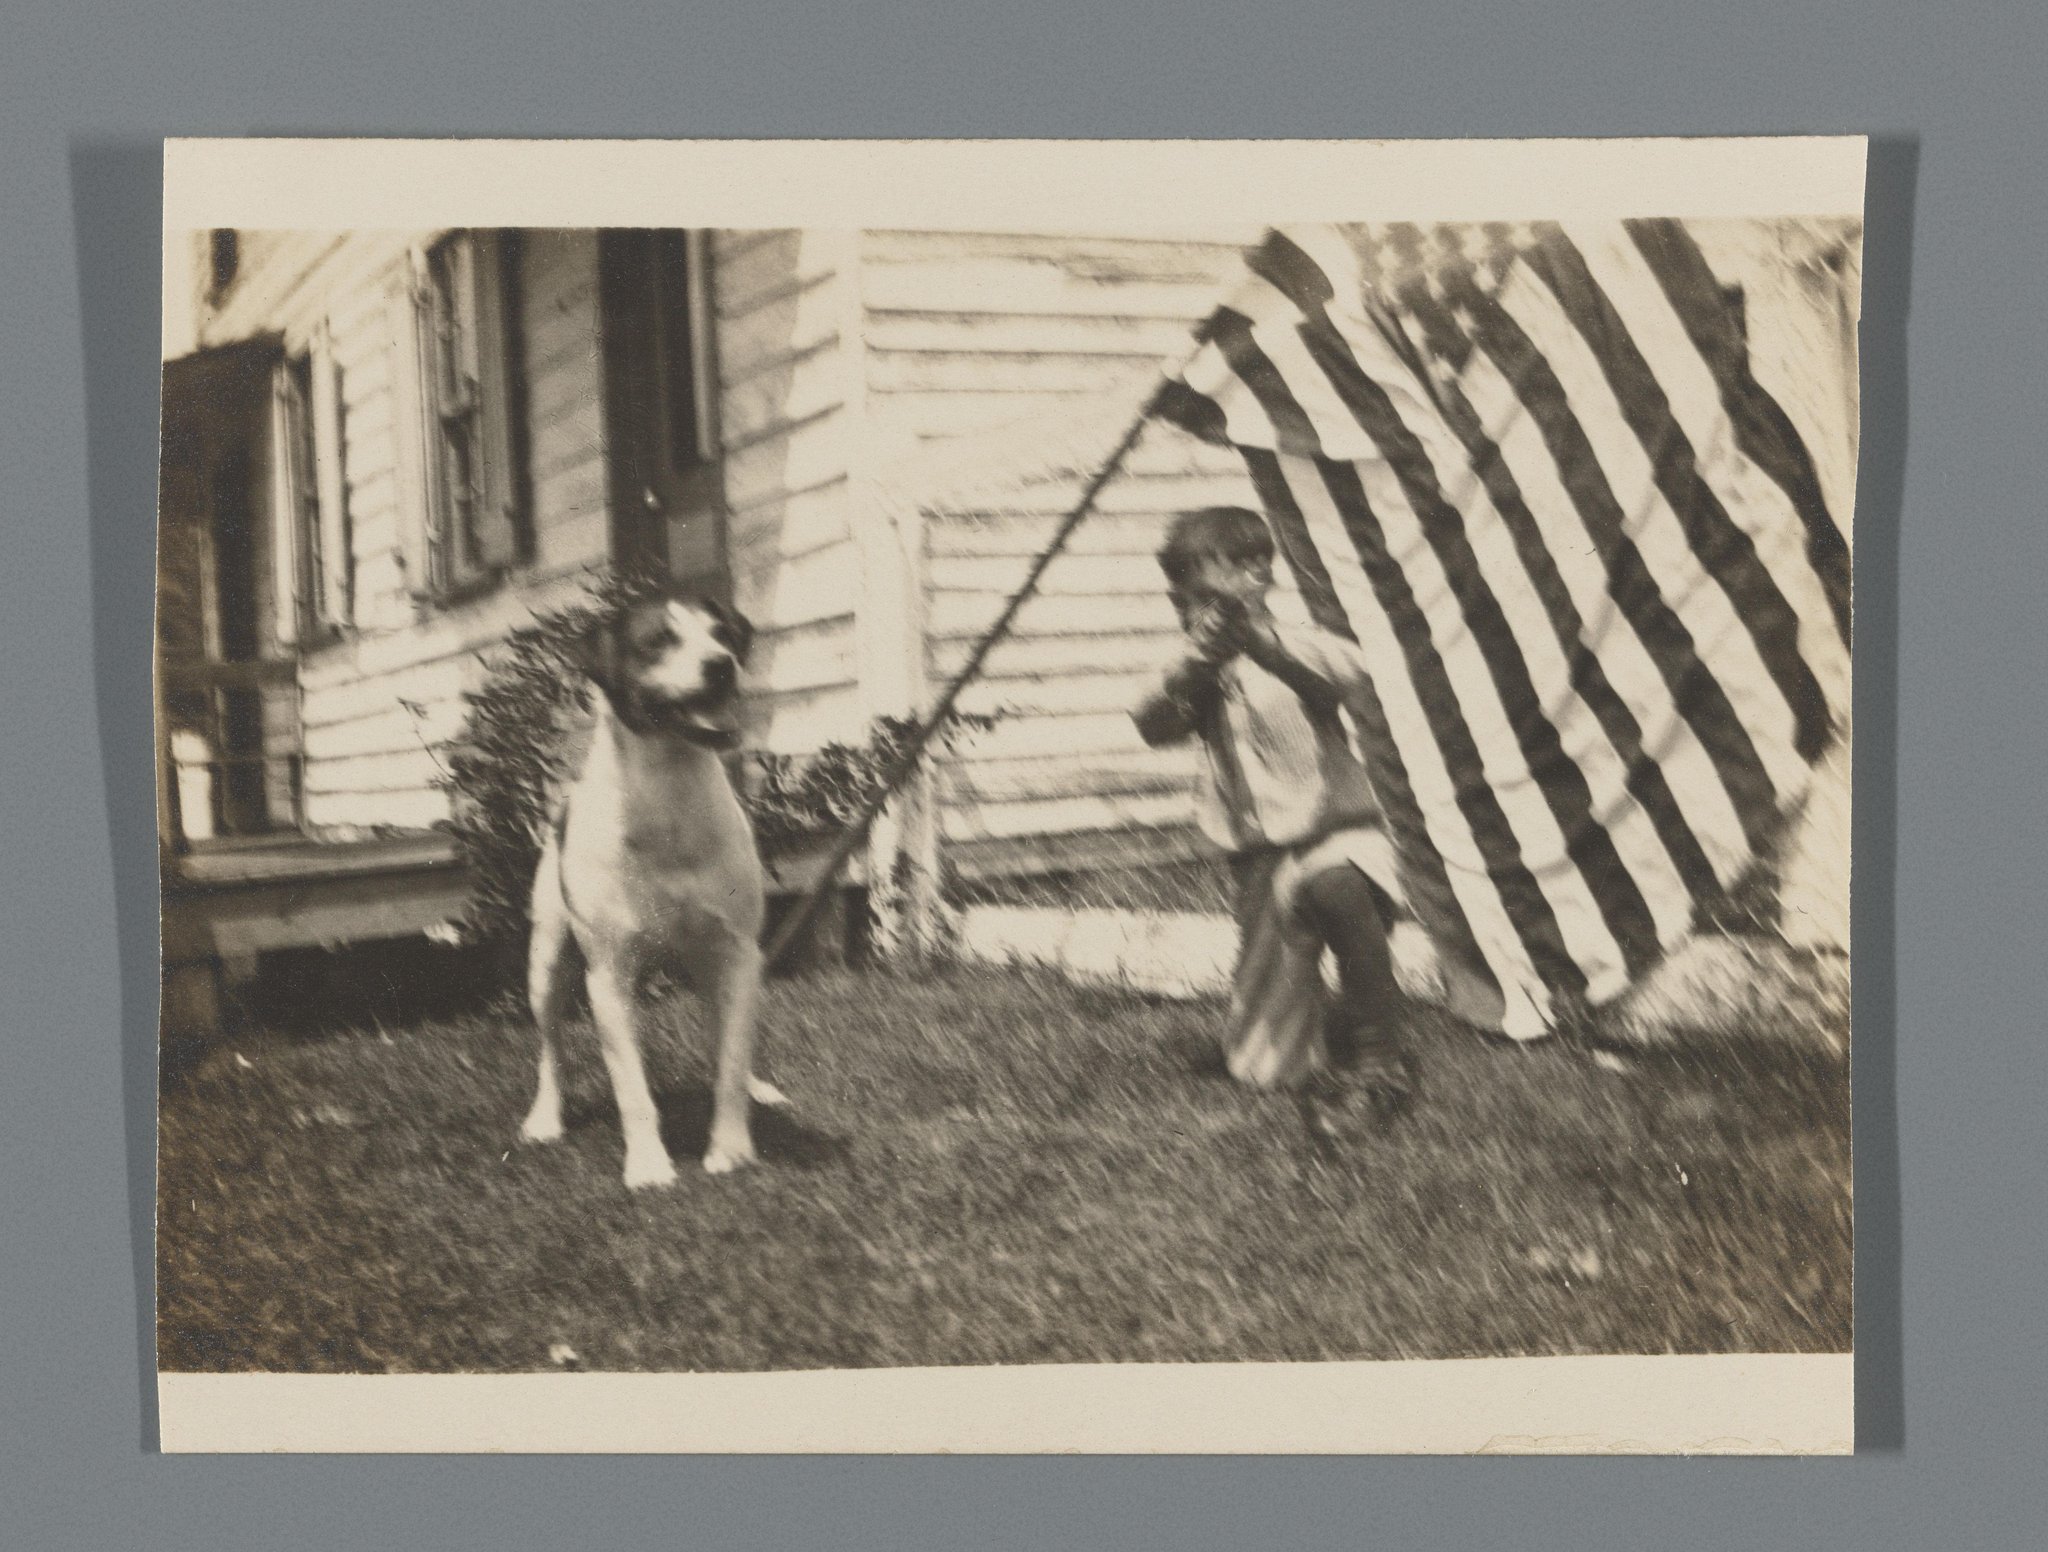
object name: photograph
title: Jongen met hond, geweer en Amerikaanse vlag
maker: Anonymous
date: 1930-1950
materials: paper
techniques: gelatin silver print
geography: united states